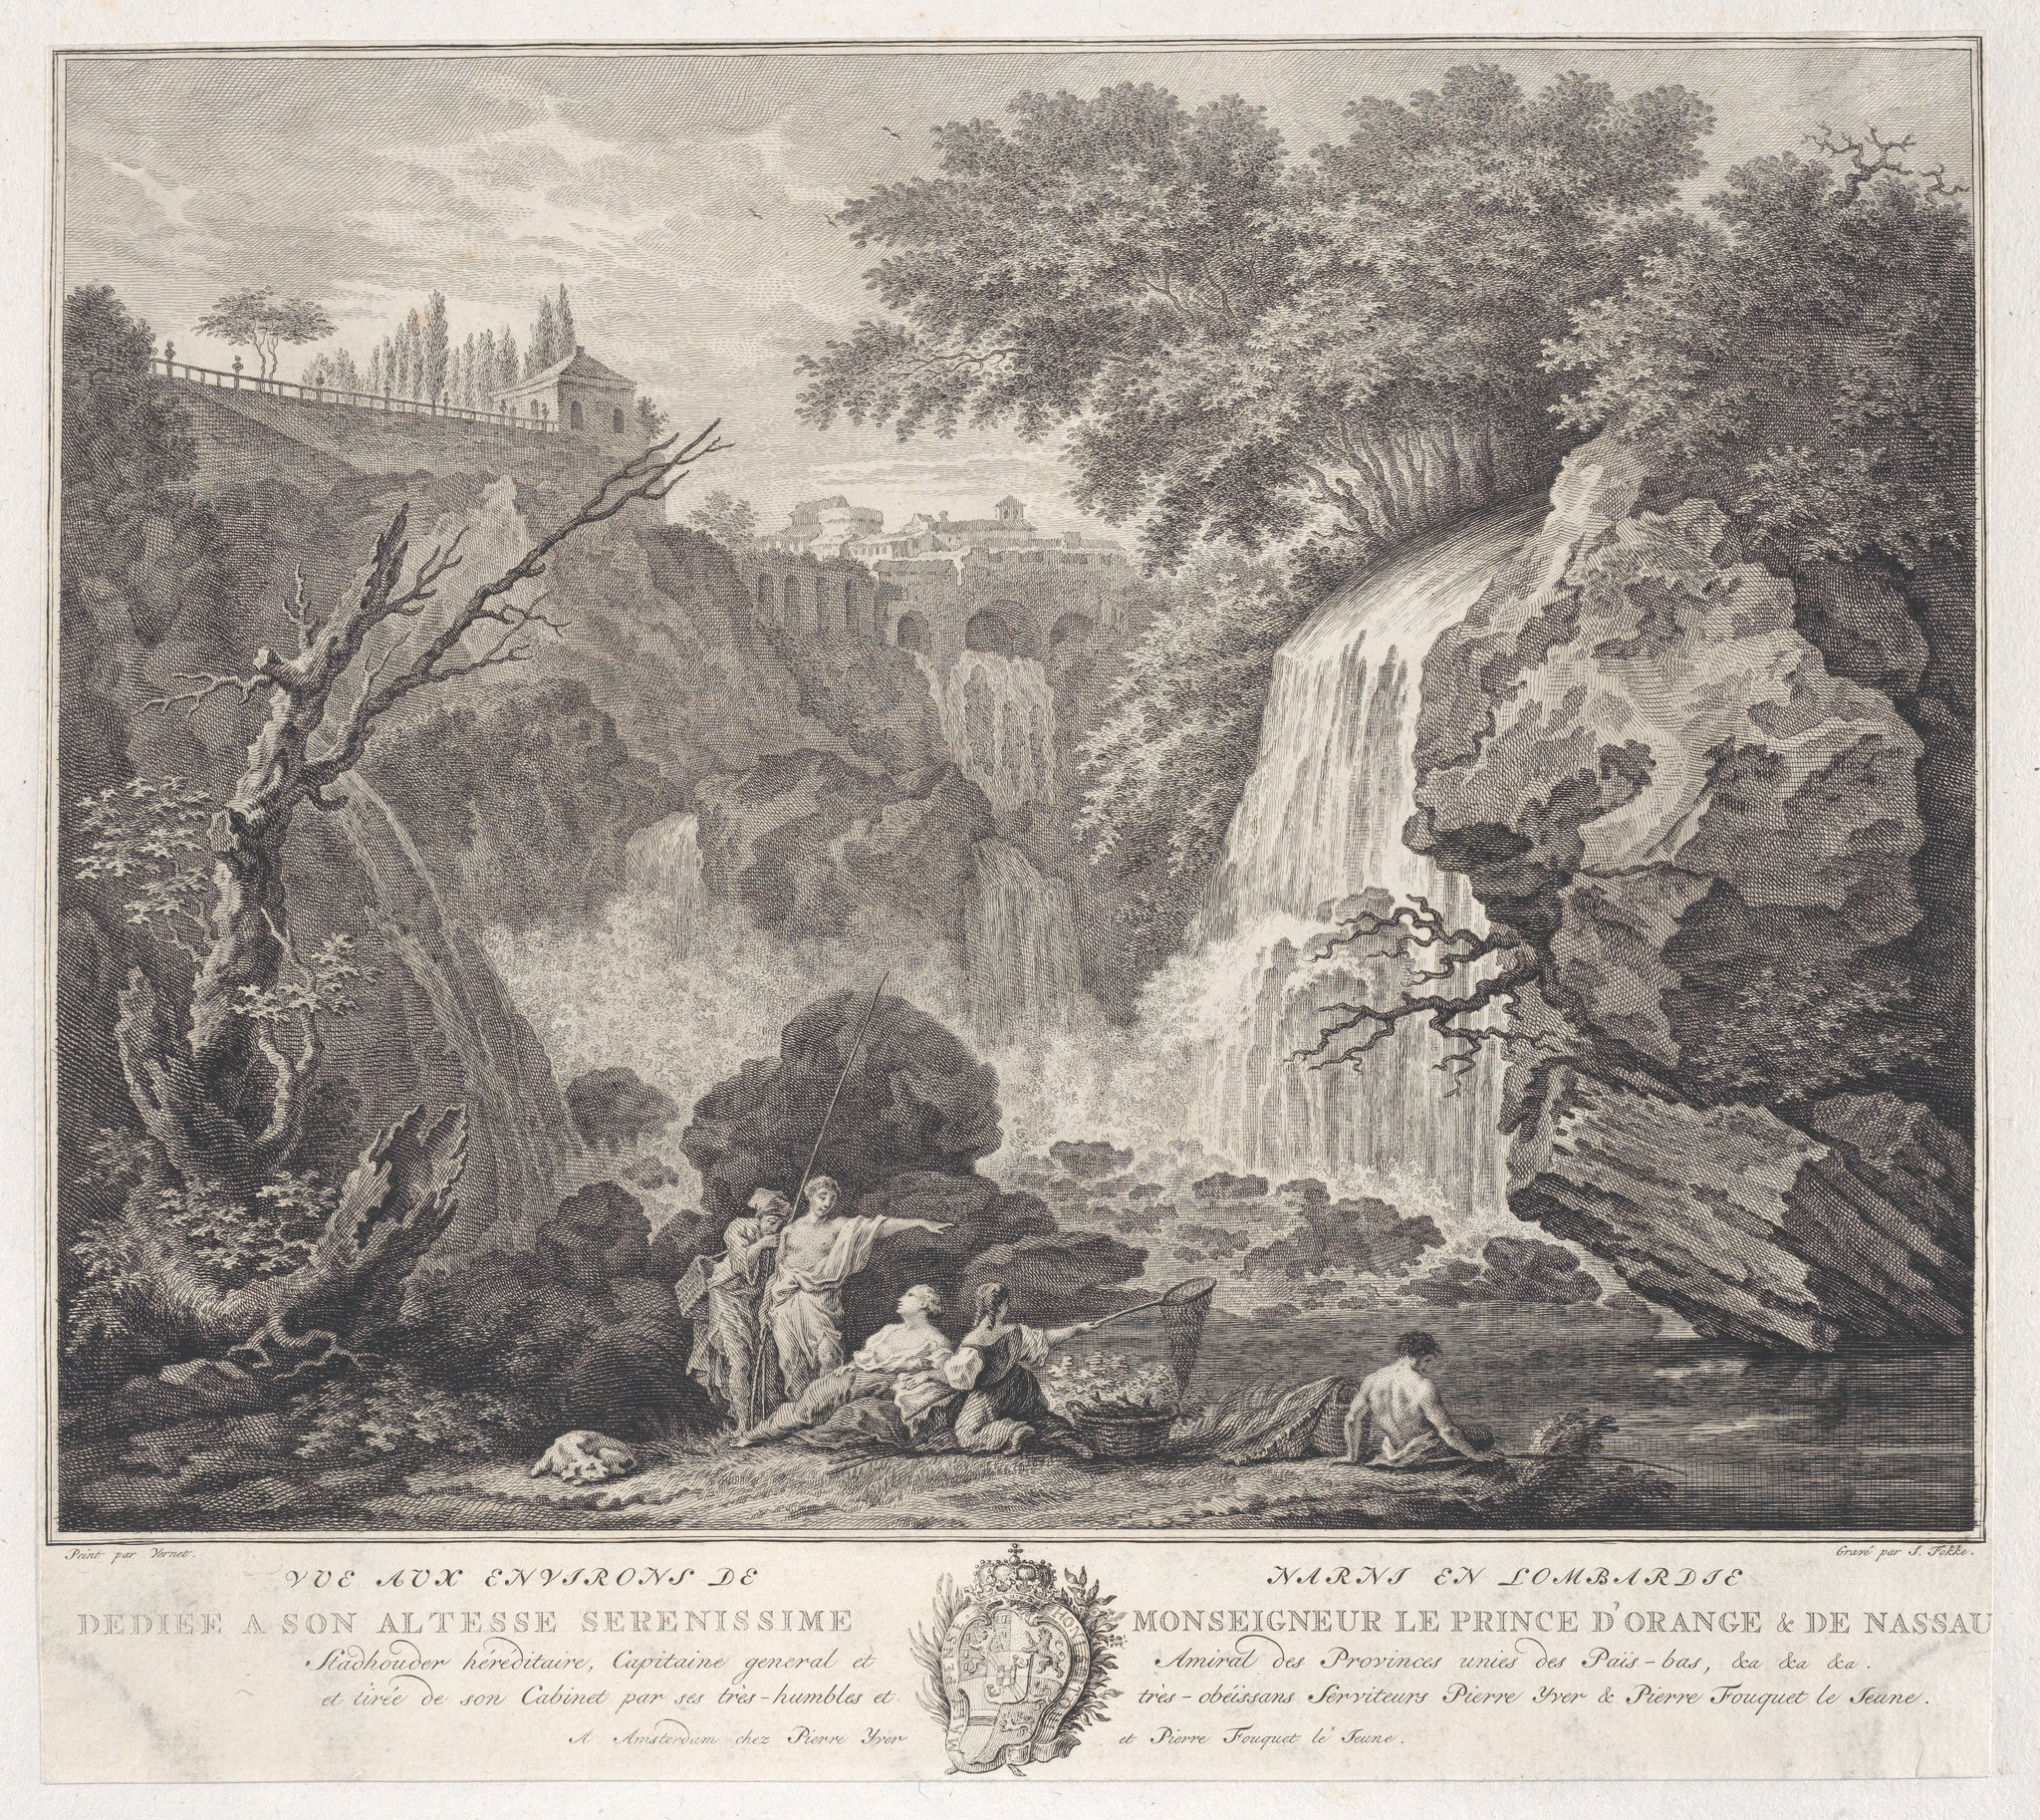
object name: print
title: View of the Surroundings of Narni in Lombardy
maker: joseph vernet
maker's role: artist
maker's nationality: french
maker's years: 1714-1789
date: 1770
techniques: engraving